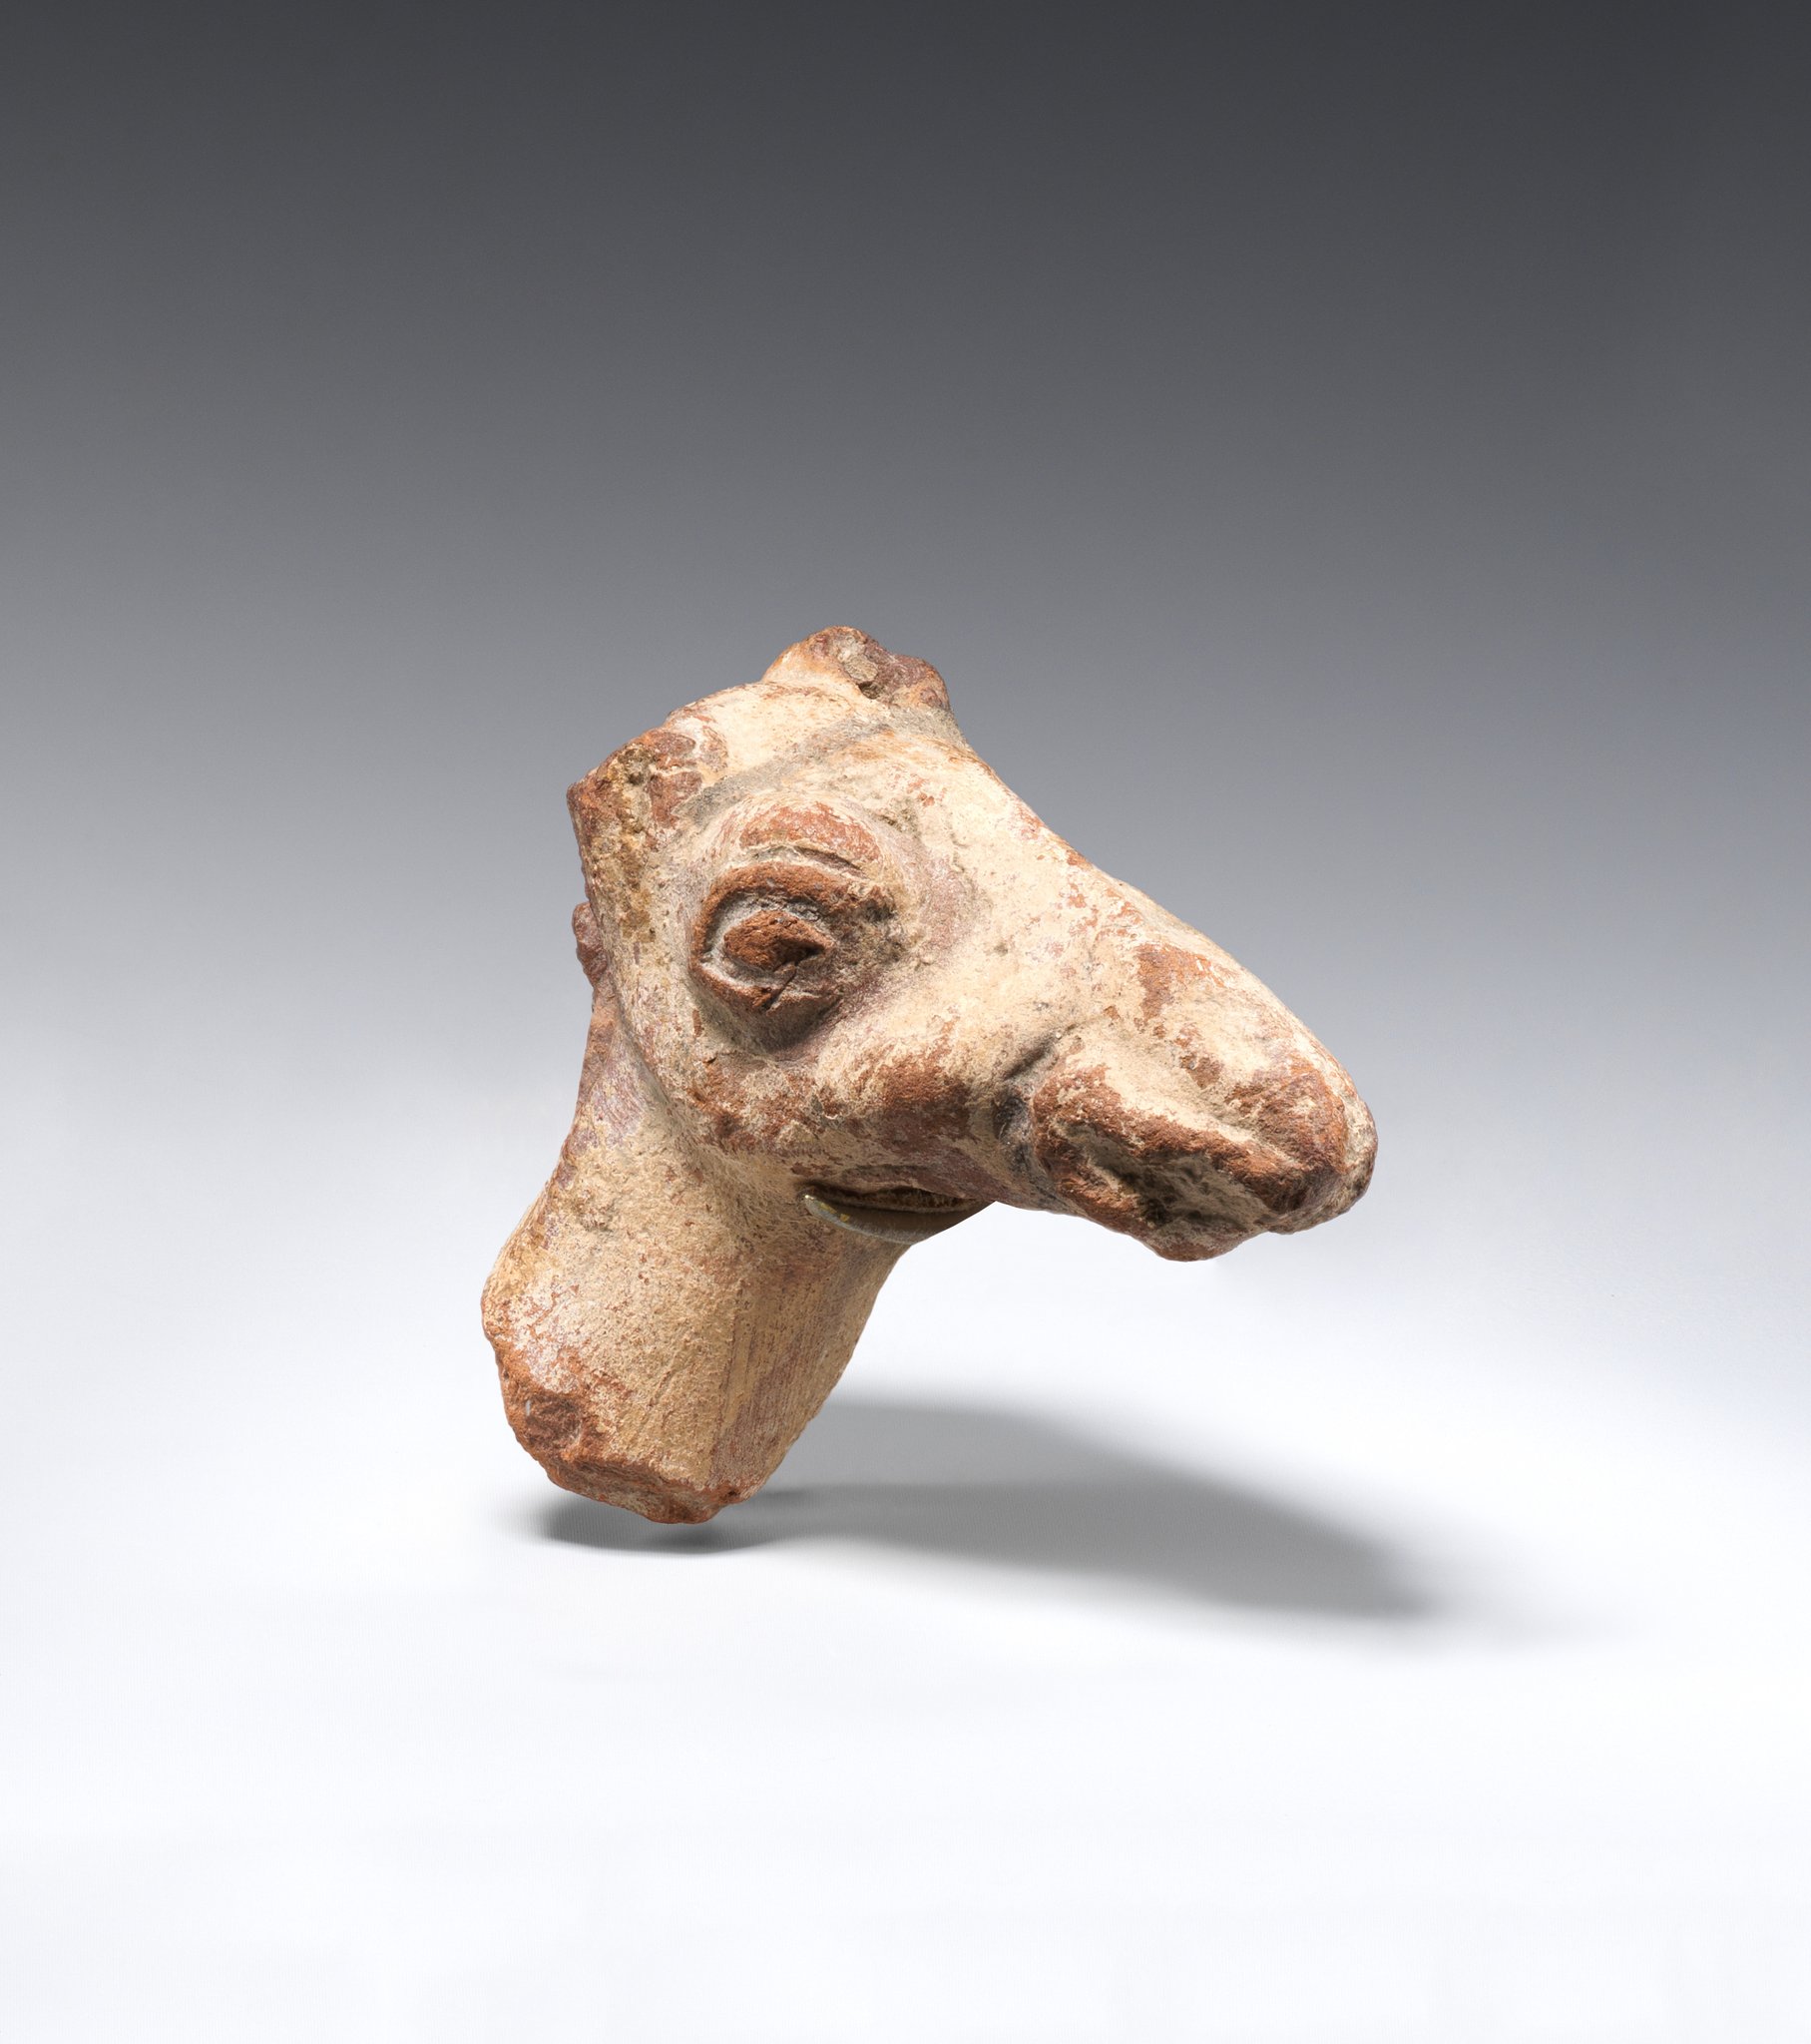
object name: head, camel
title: Head from the figure of a camel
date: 332-330 BCE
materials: terracotta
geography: egypt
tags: camels